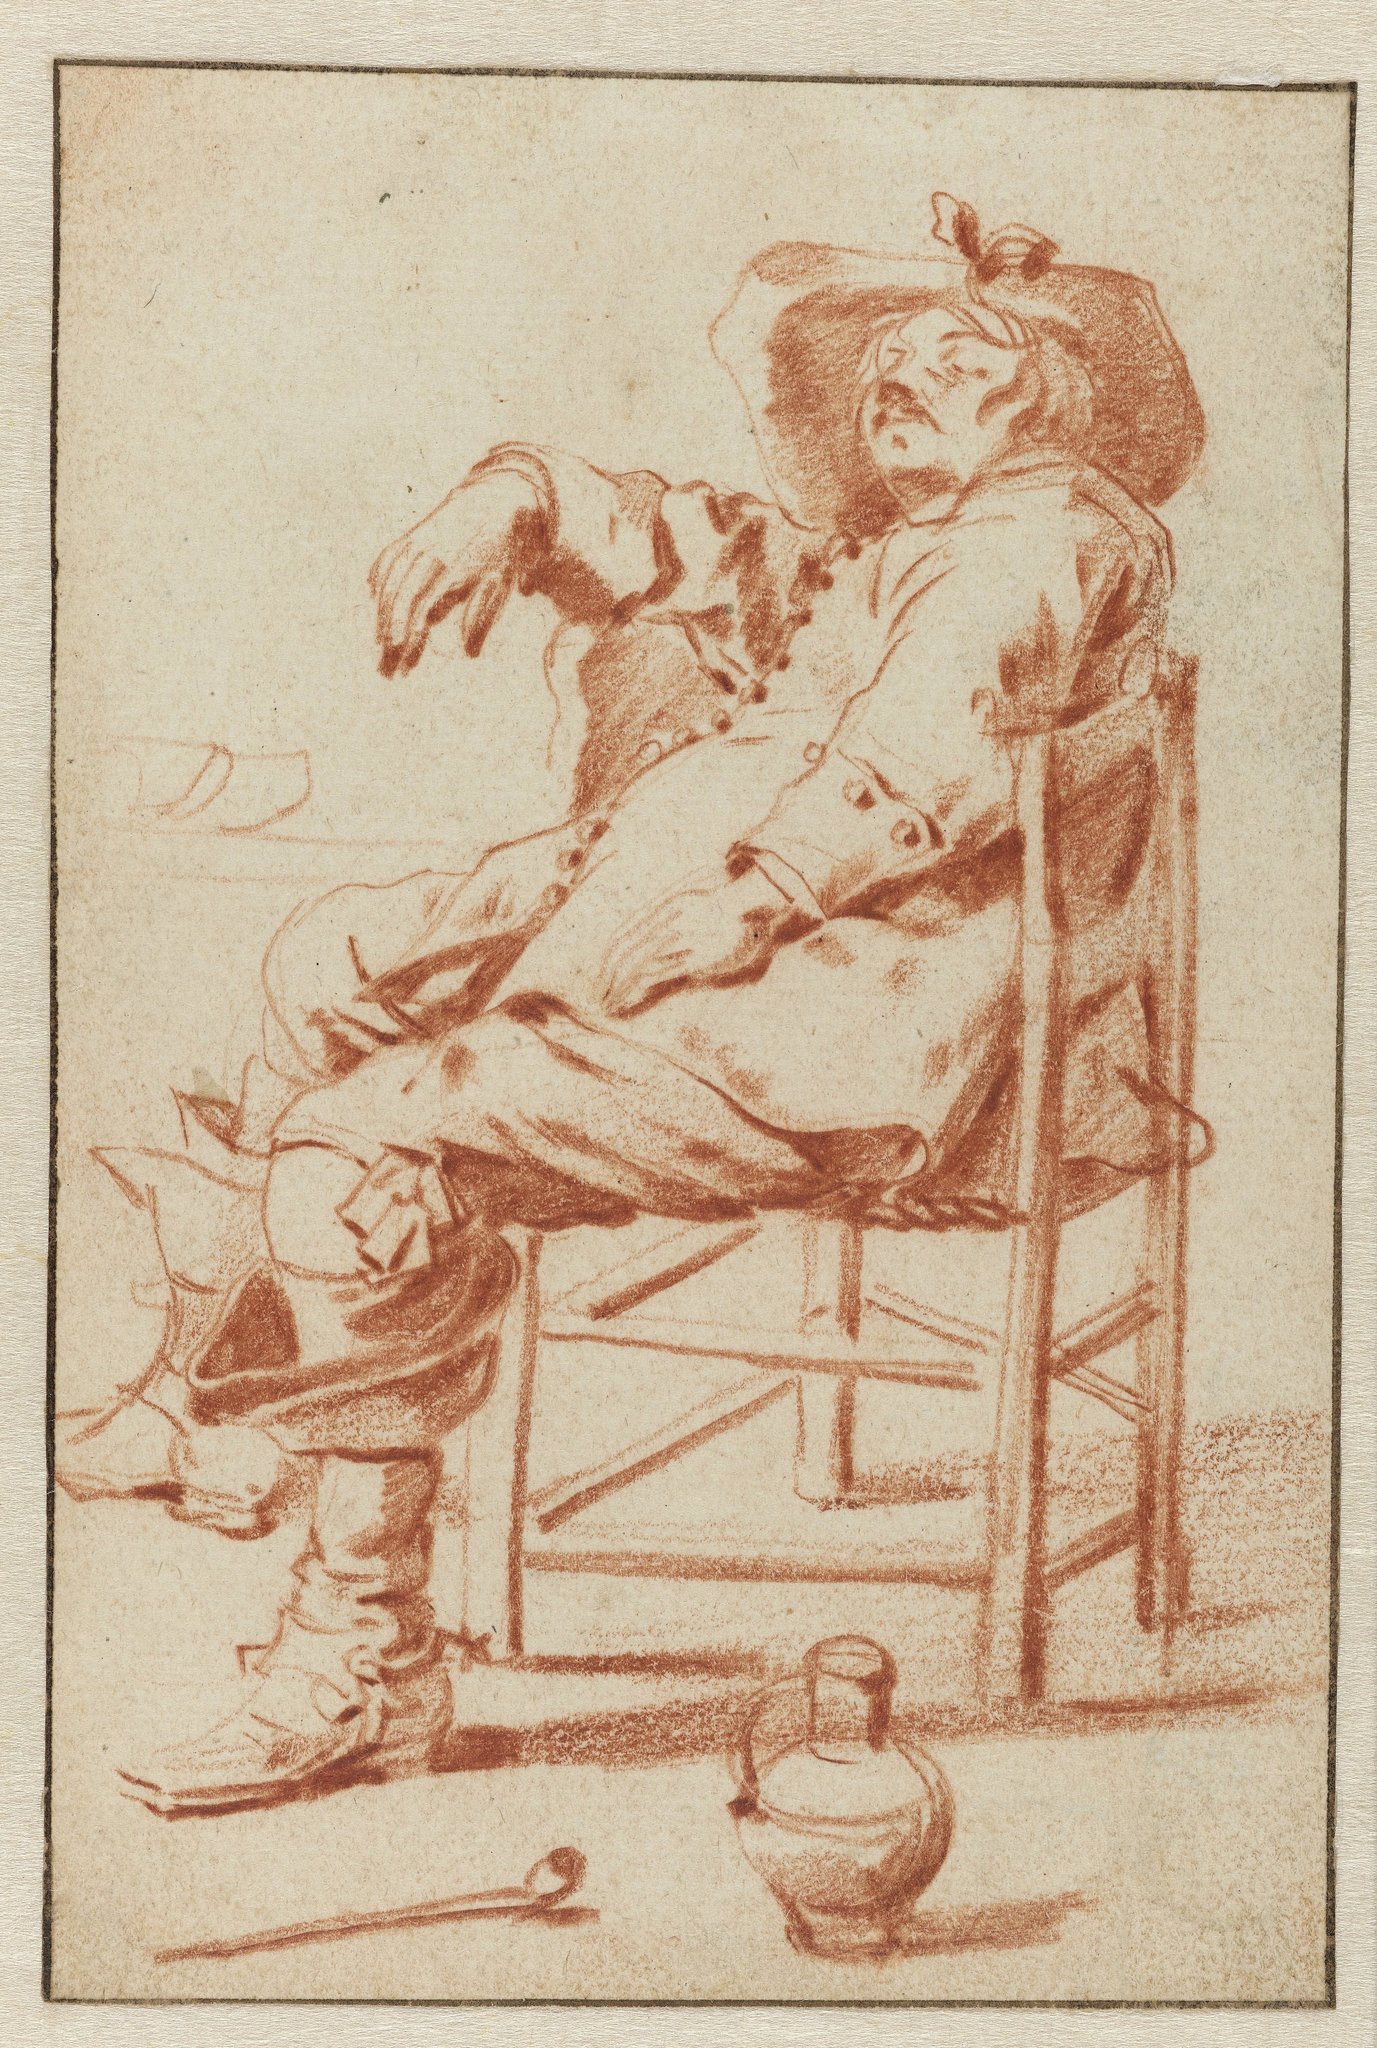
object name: drawing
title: Man op een stoel zittend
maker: adriaen van de velde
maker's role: draughtsman, painter, print maker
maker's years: 1636-1672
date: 1646-1672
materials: chalk, paper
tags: sitting figure, chair